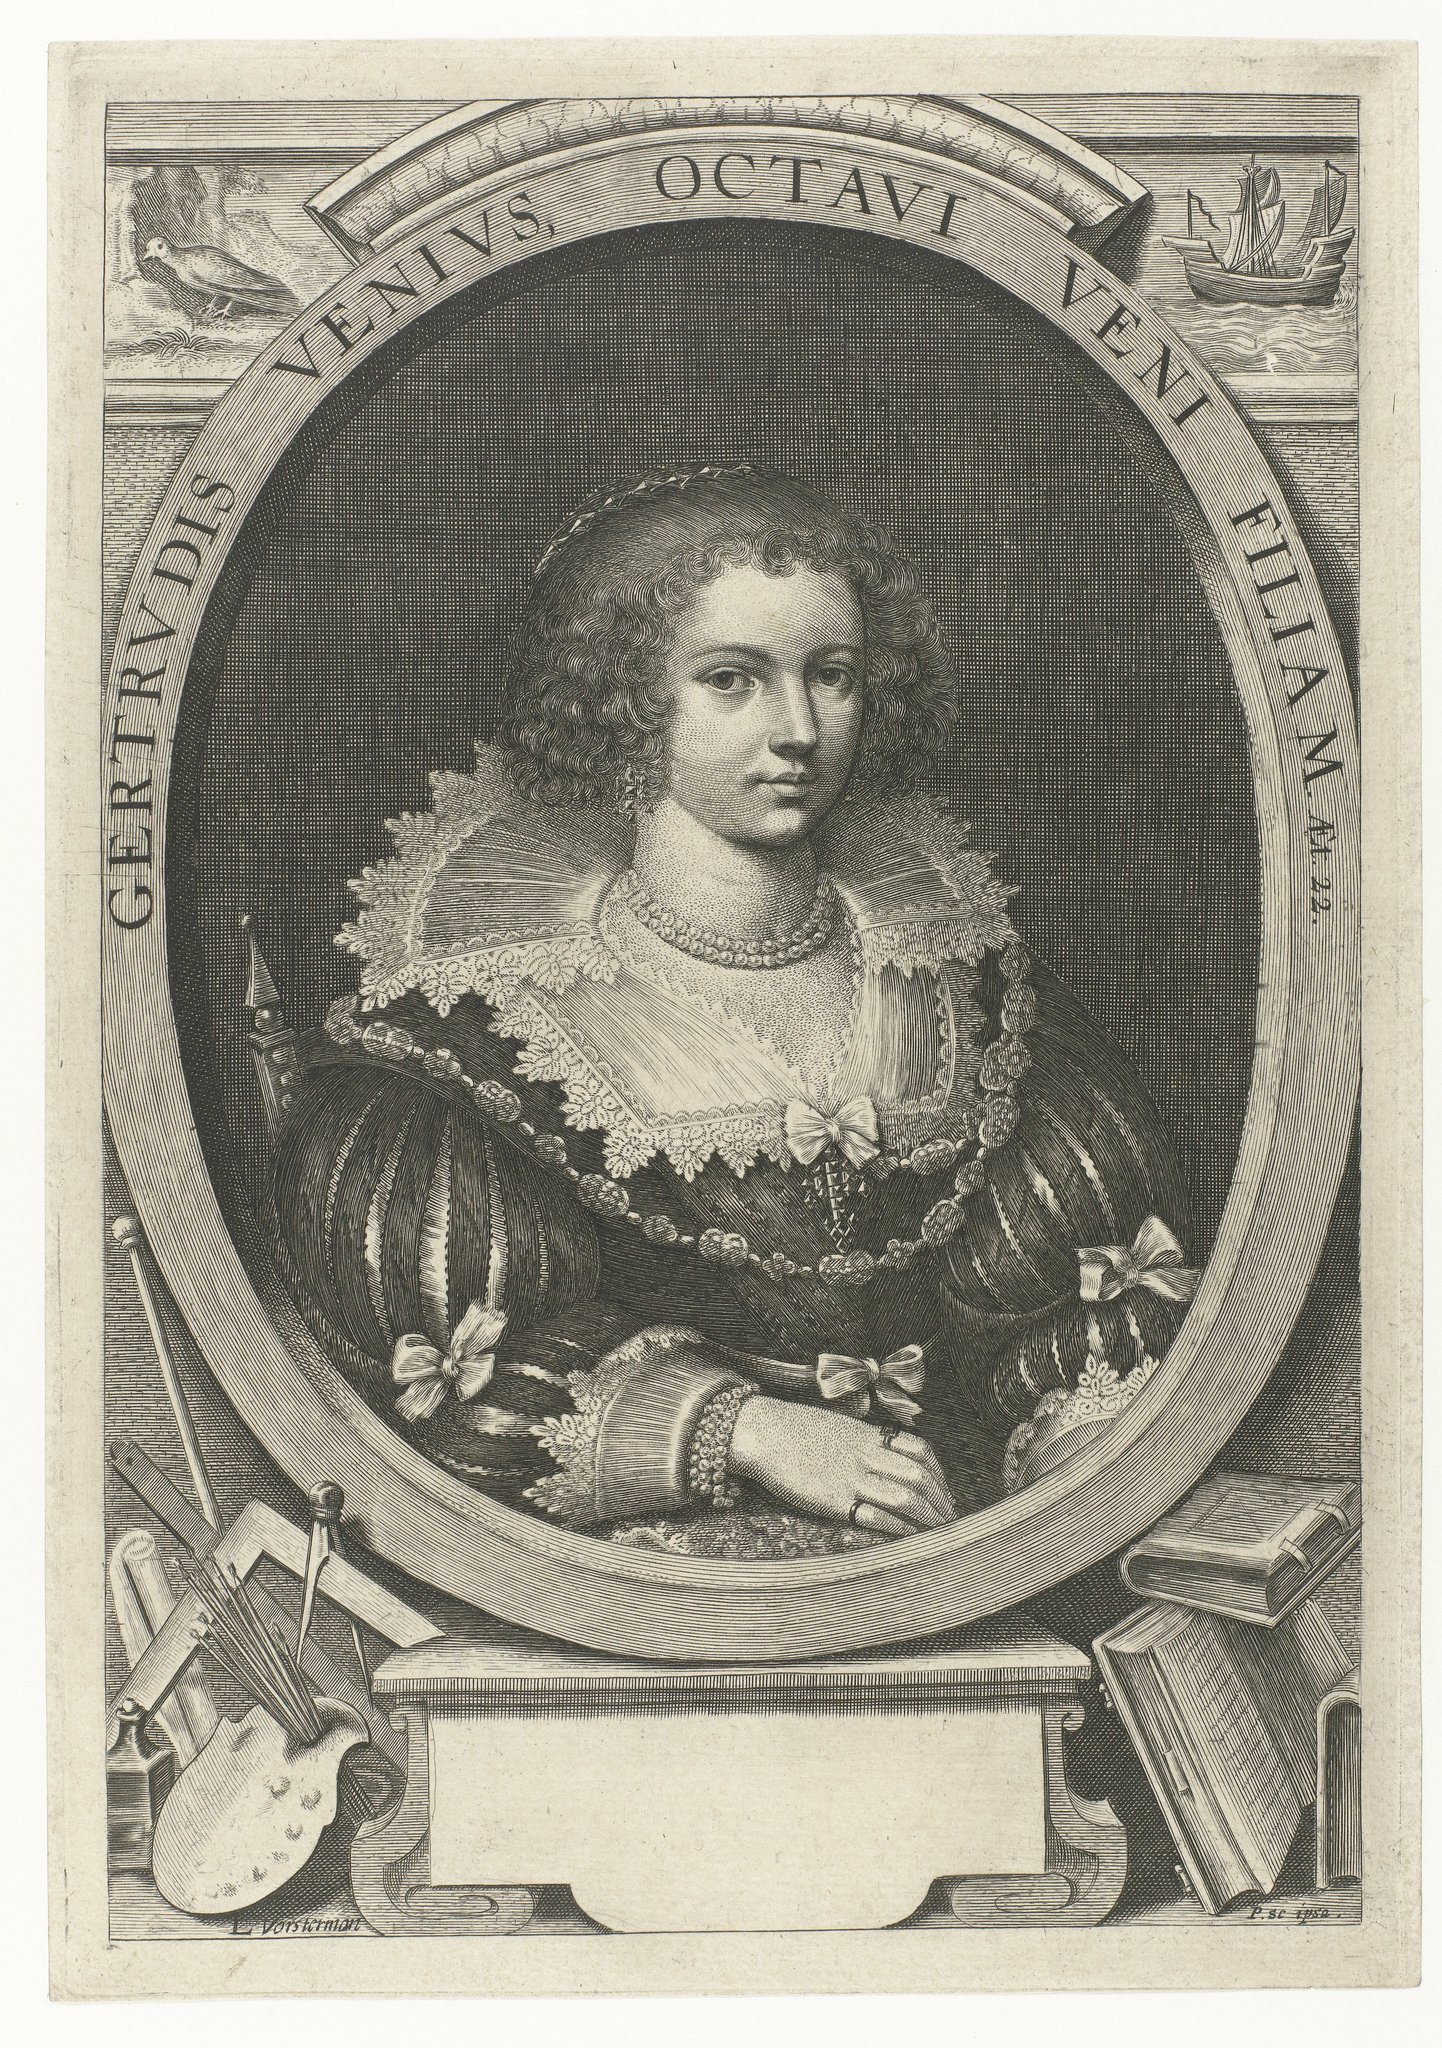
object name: print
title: Portret van Geertruida van Veen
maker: lucas vorsterman (i)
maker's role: print maker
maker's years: 1595-1675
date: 1624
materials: paper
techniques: engraving, pen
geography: antwerp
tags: antwerp, painter, draughtsman, gertruida van veen, bow (ornamental part of clothing) (+ women's clothes), ring (+ women's clothes), neck-gear: collar (+ women's clothes), neck-gear: collar (+ lace used for clothes), hairdress - aa - ~ women, sleeves: cuffs (+ women's clothes), portrait, self-portrait of painter, sleeves (+ women's clothes), necklace (+ women's clothes), clothing for the upper part of the body (with name) (+ women's clothes), low countries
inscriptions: collector's mark: Lugt 567, inscription: ‘een regel in het Frans’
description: Portret van deAntwerpse schilderes Geertruida van Veen (dochter van Otto van Veen) op 22-jarige leeftijd. Buste naar rechts, in ovaal, gekleed in elegante japon met grote platliggende kanten kraag. Linksonder de attributen van de schilder- en tekenkunst; rechtsonder enkele boeken.